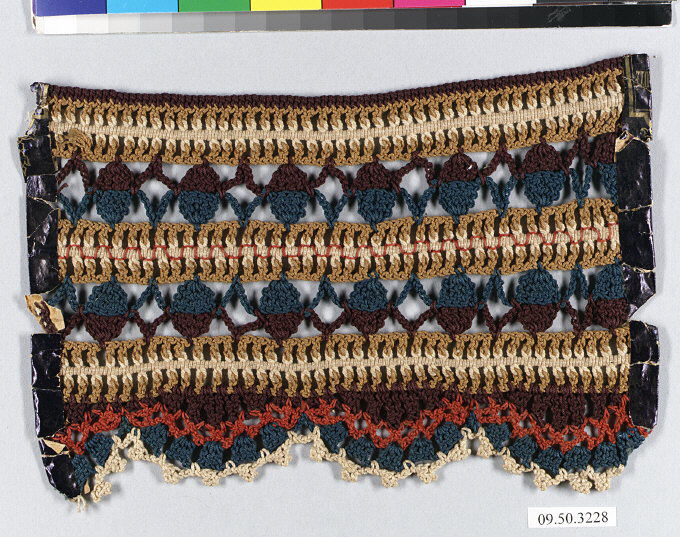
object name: sample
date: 1801-1900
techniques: crochet